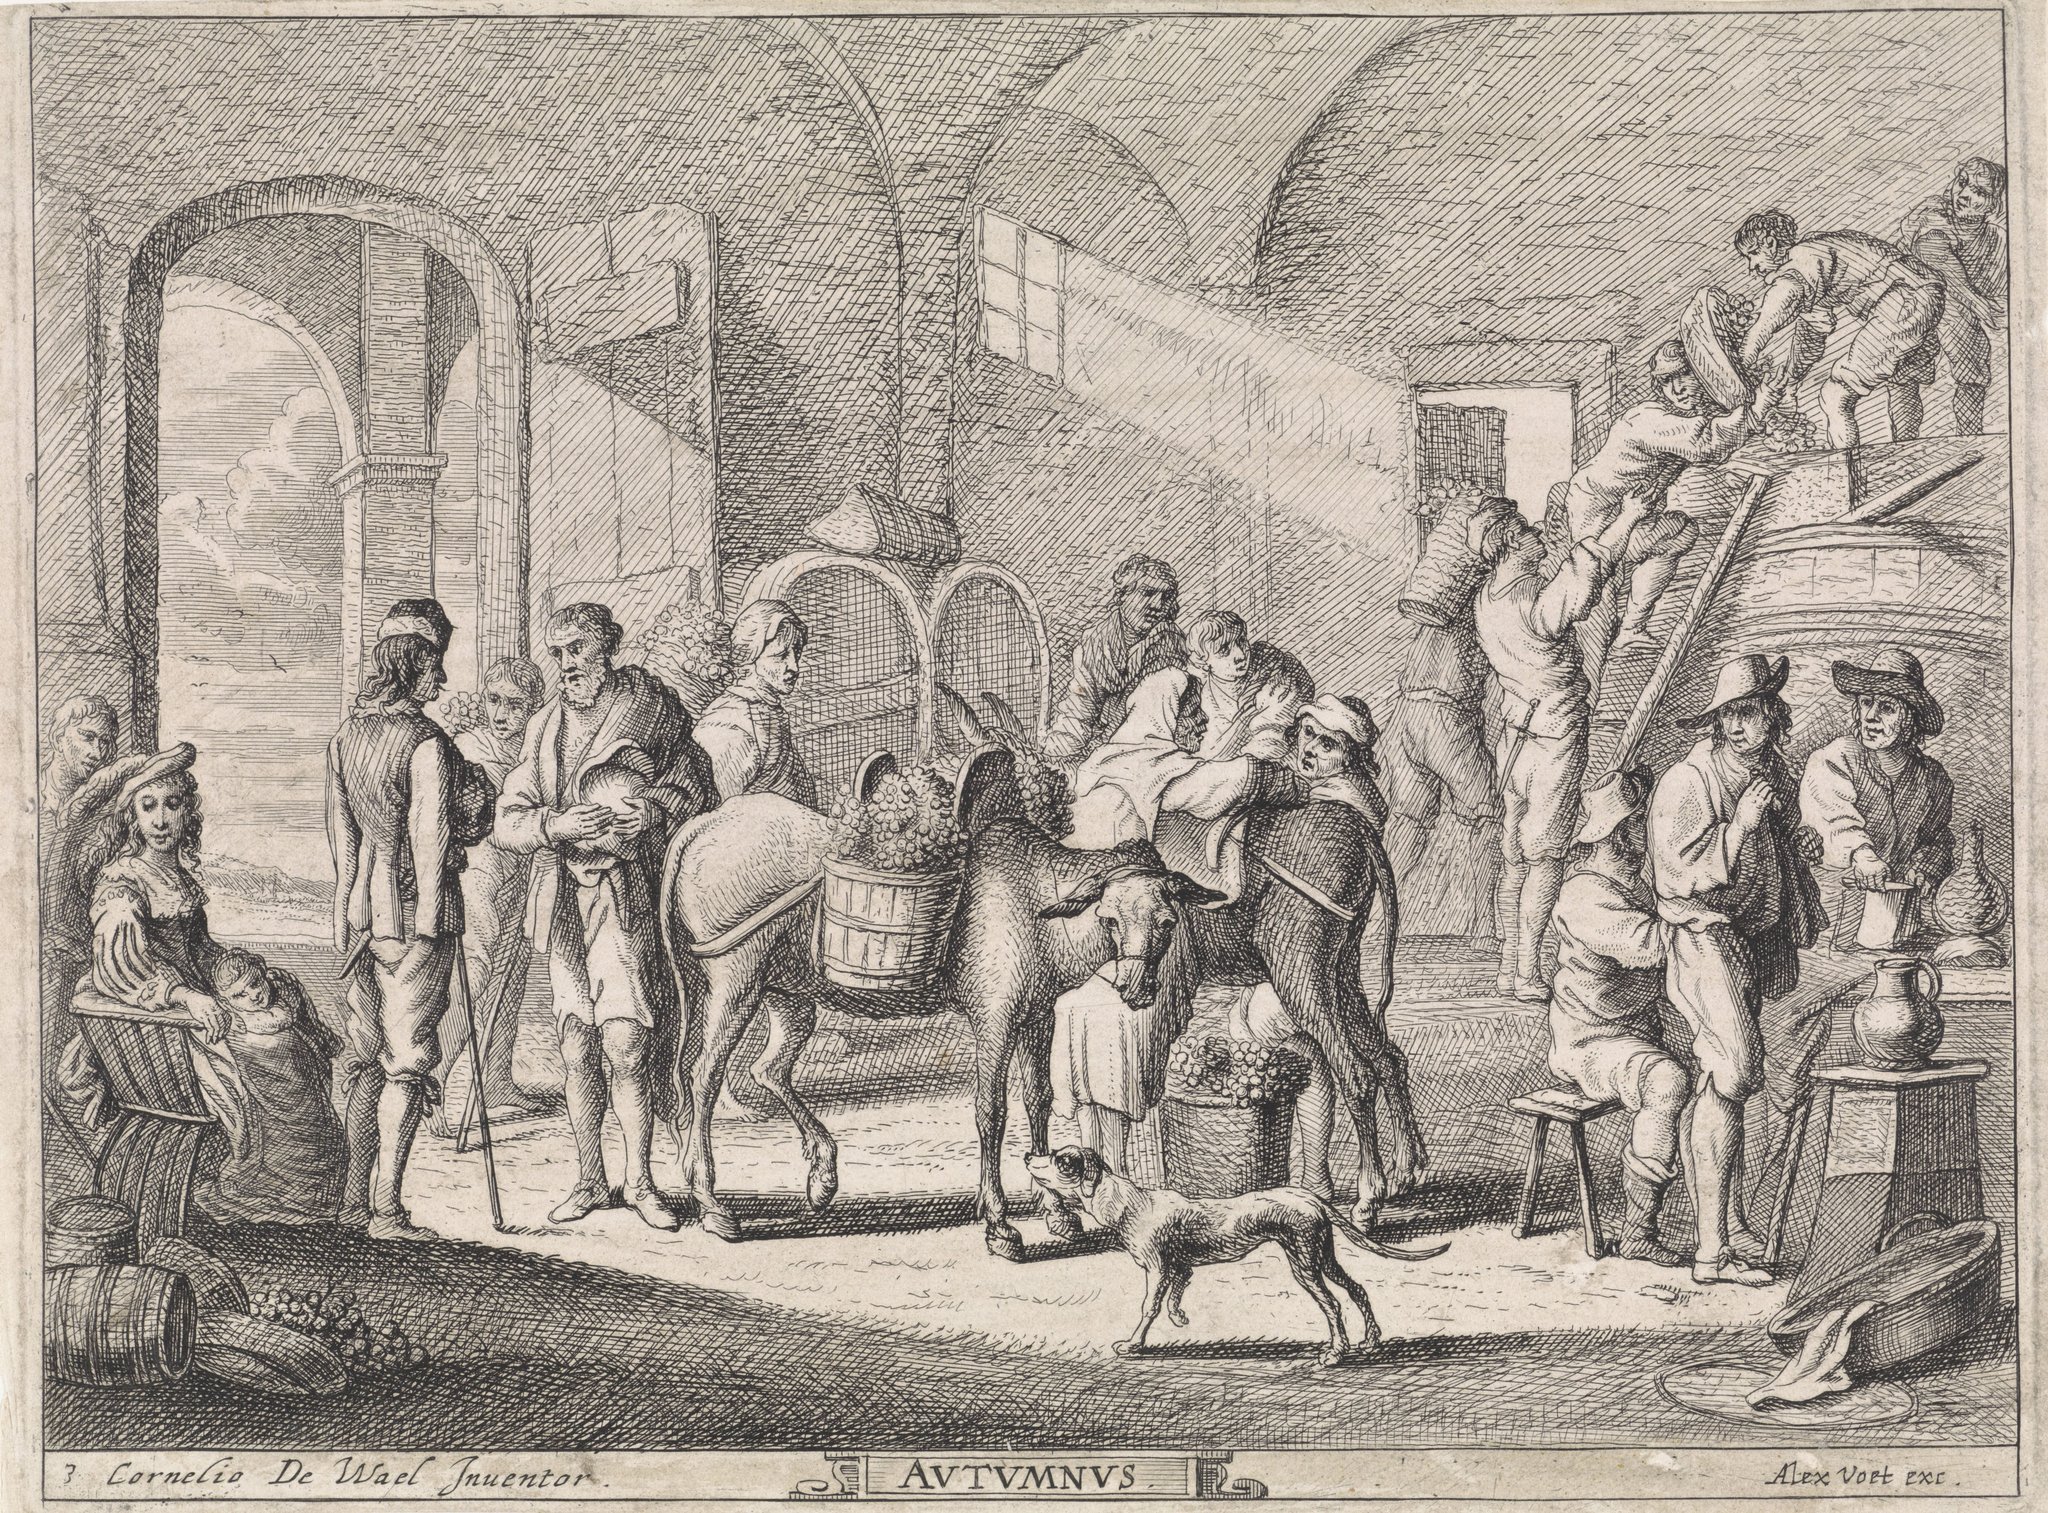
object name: print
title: Vier jaargetijden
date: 1628-1689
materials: paper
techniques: engraving, etching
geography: antwerp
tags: autumn, fall, 'autumnus'; 'autunno' (ripa)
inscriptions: collector's mark: Lugt 2228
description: Interieur van een grote hal met mannen en vrouwen. In het midden worden twee ezels van hun lading druiven ontdaan, die ze in manden op hun rug dragen. Rechts op de achtergrond worden de druiven in een vat gegooid om ze te persen.